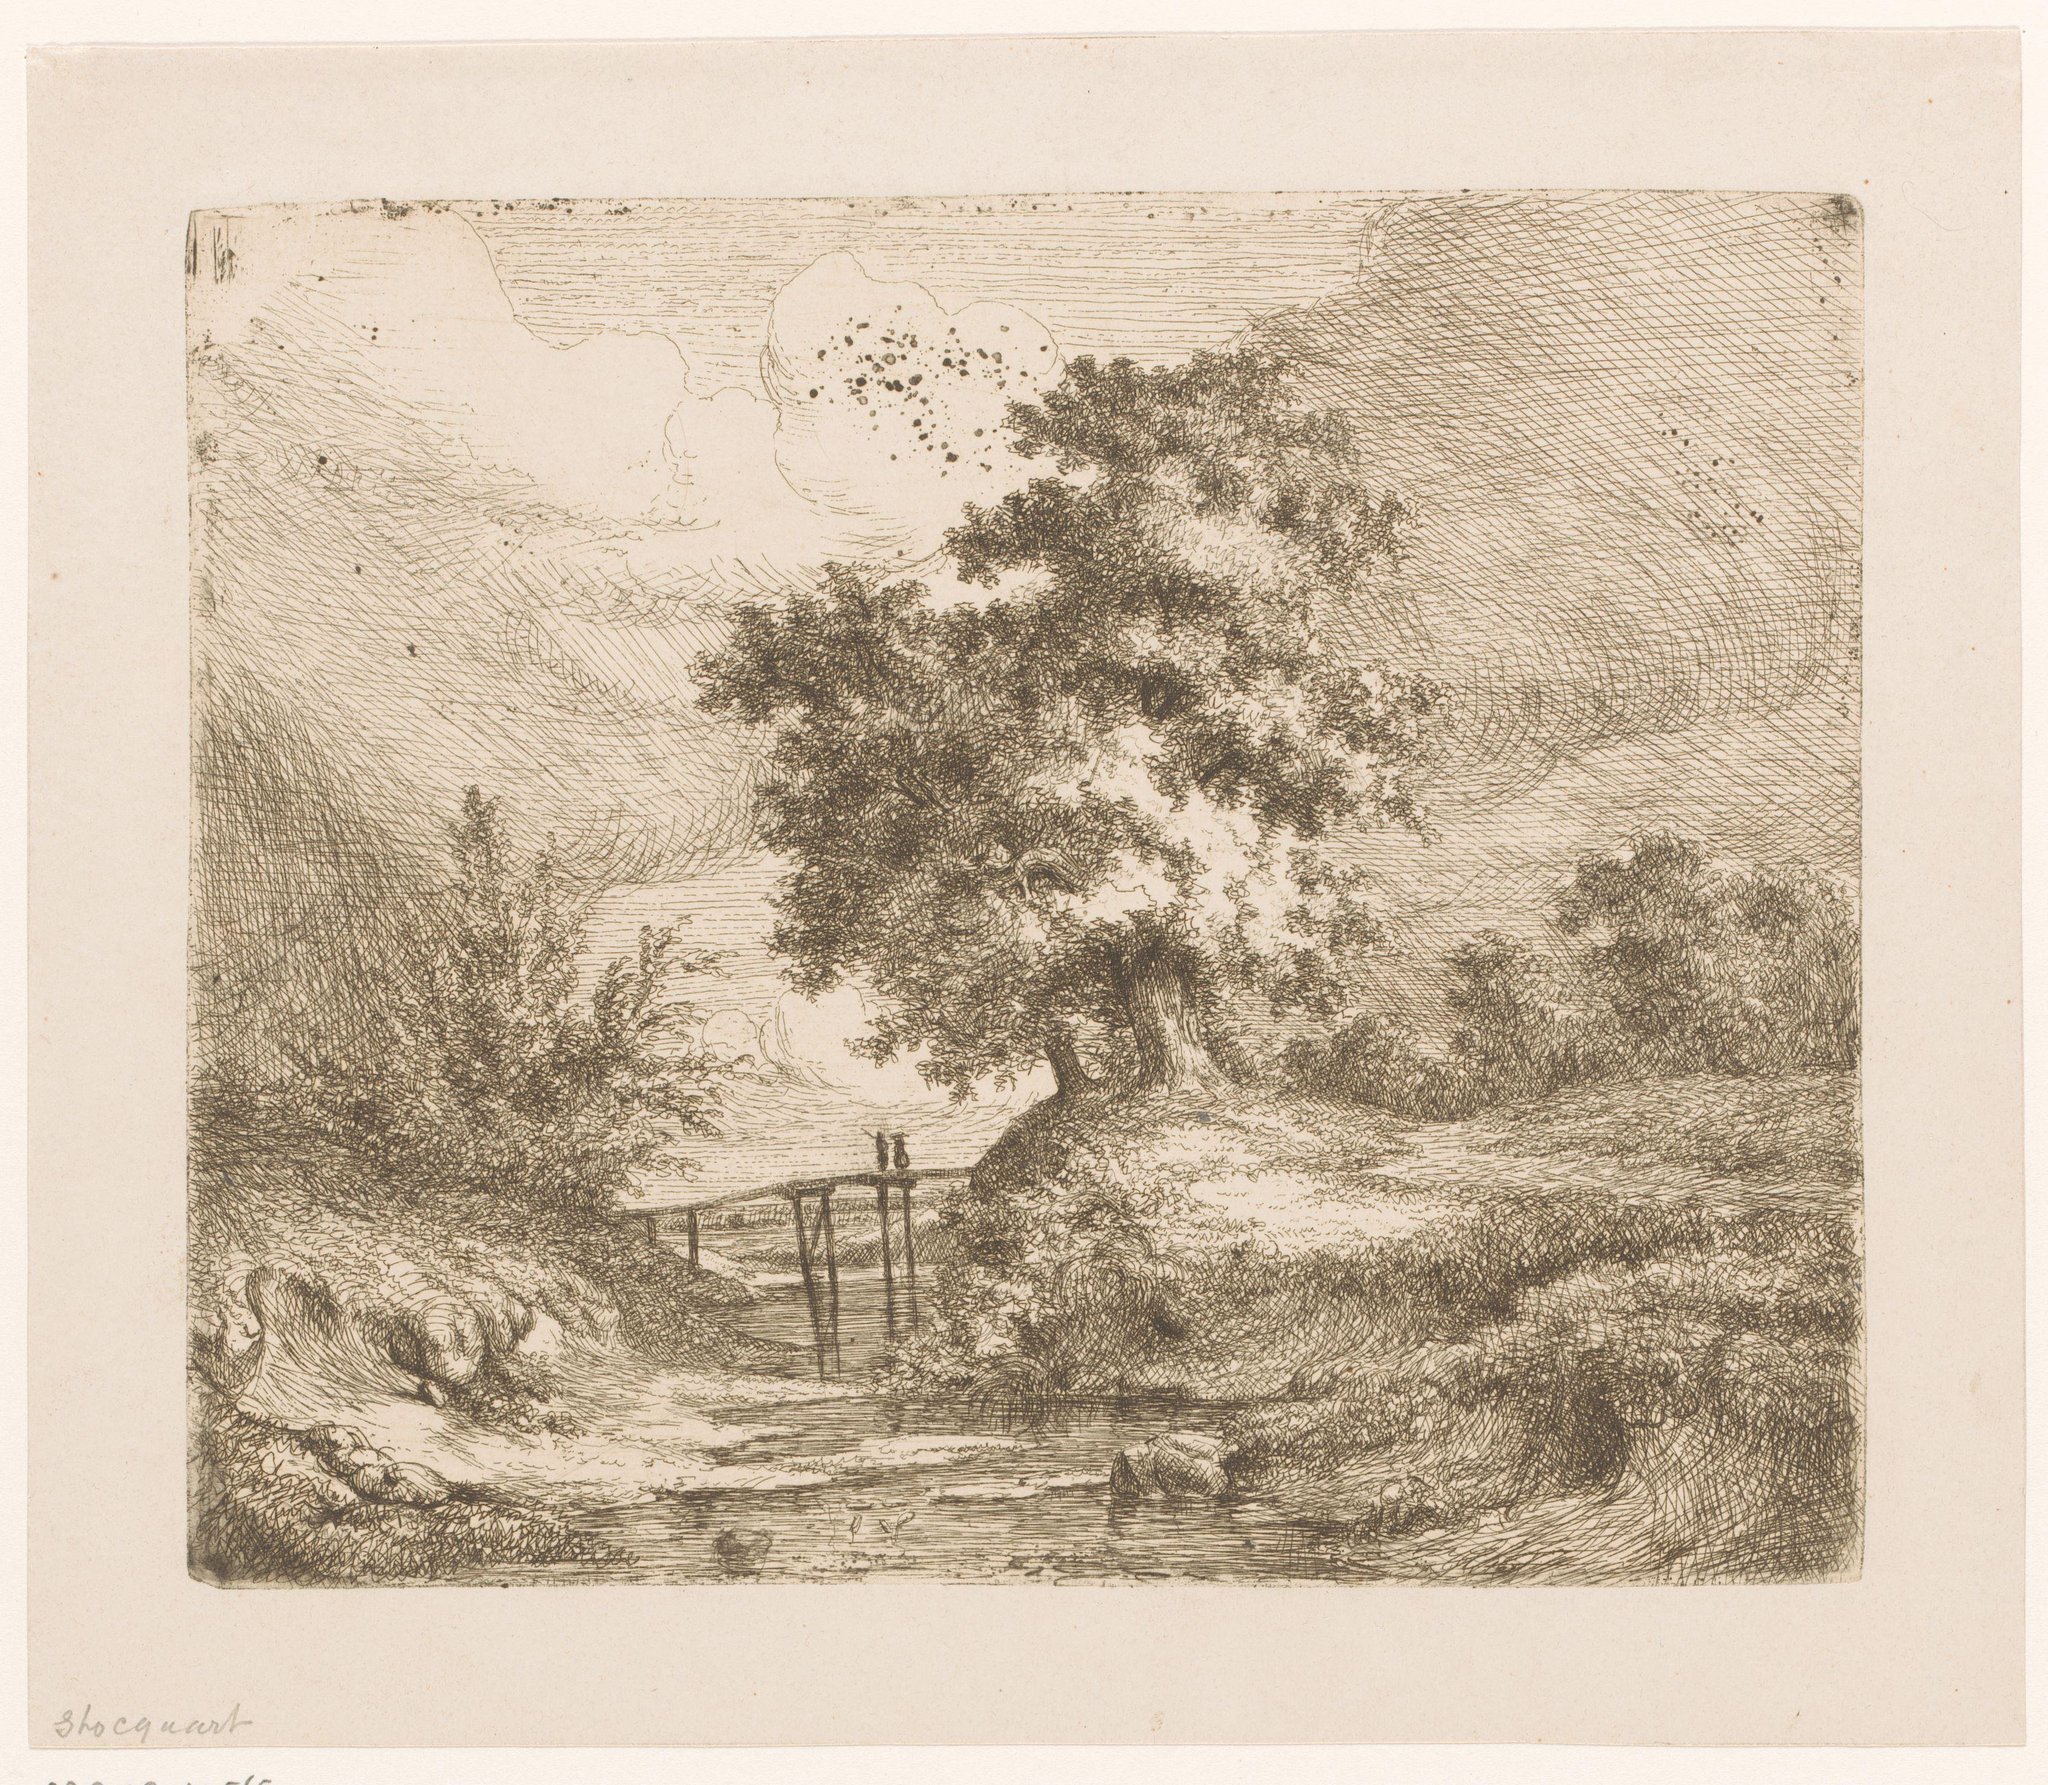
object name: print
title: Landschap met houten brug over het water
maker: ildephonse stocquart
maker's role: print maker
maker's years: 1819-1889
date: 1829-1879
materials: paper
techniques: etching, intaglio, retroussage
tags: landscape with bridge, viaduct or aqueduct, brook (+ landscape with figures, staffage)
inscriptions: collector's mark: Lugt 2228